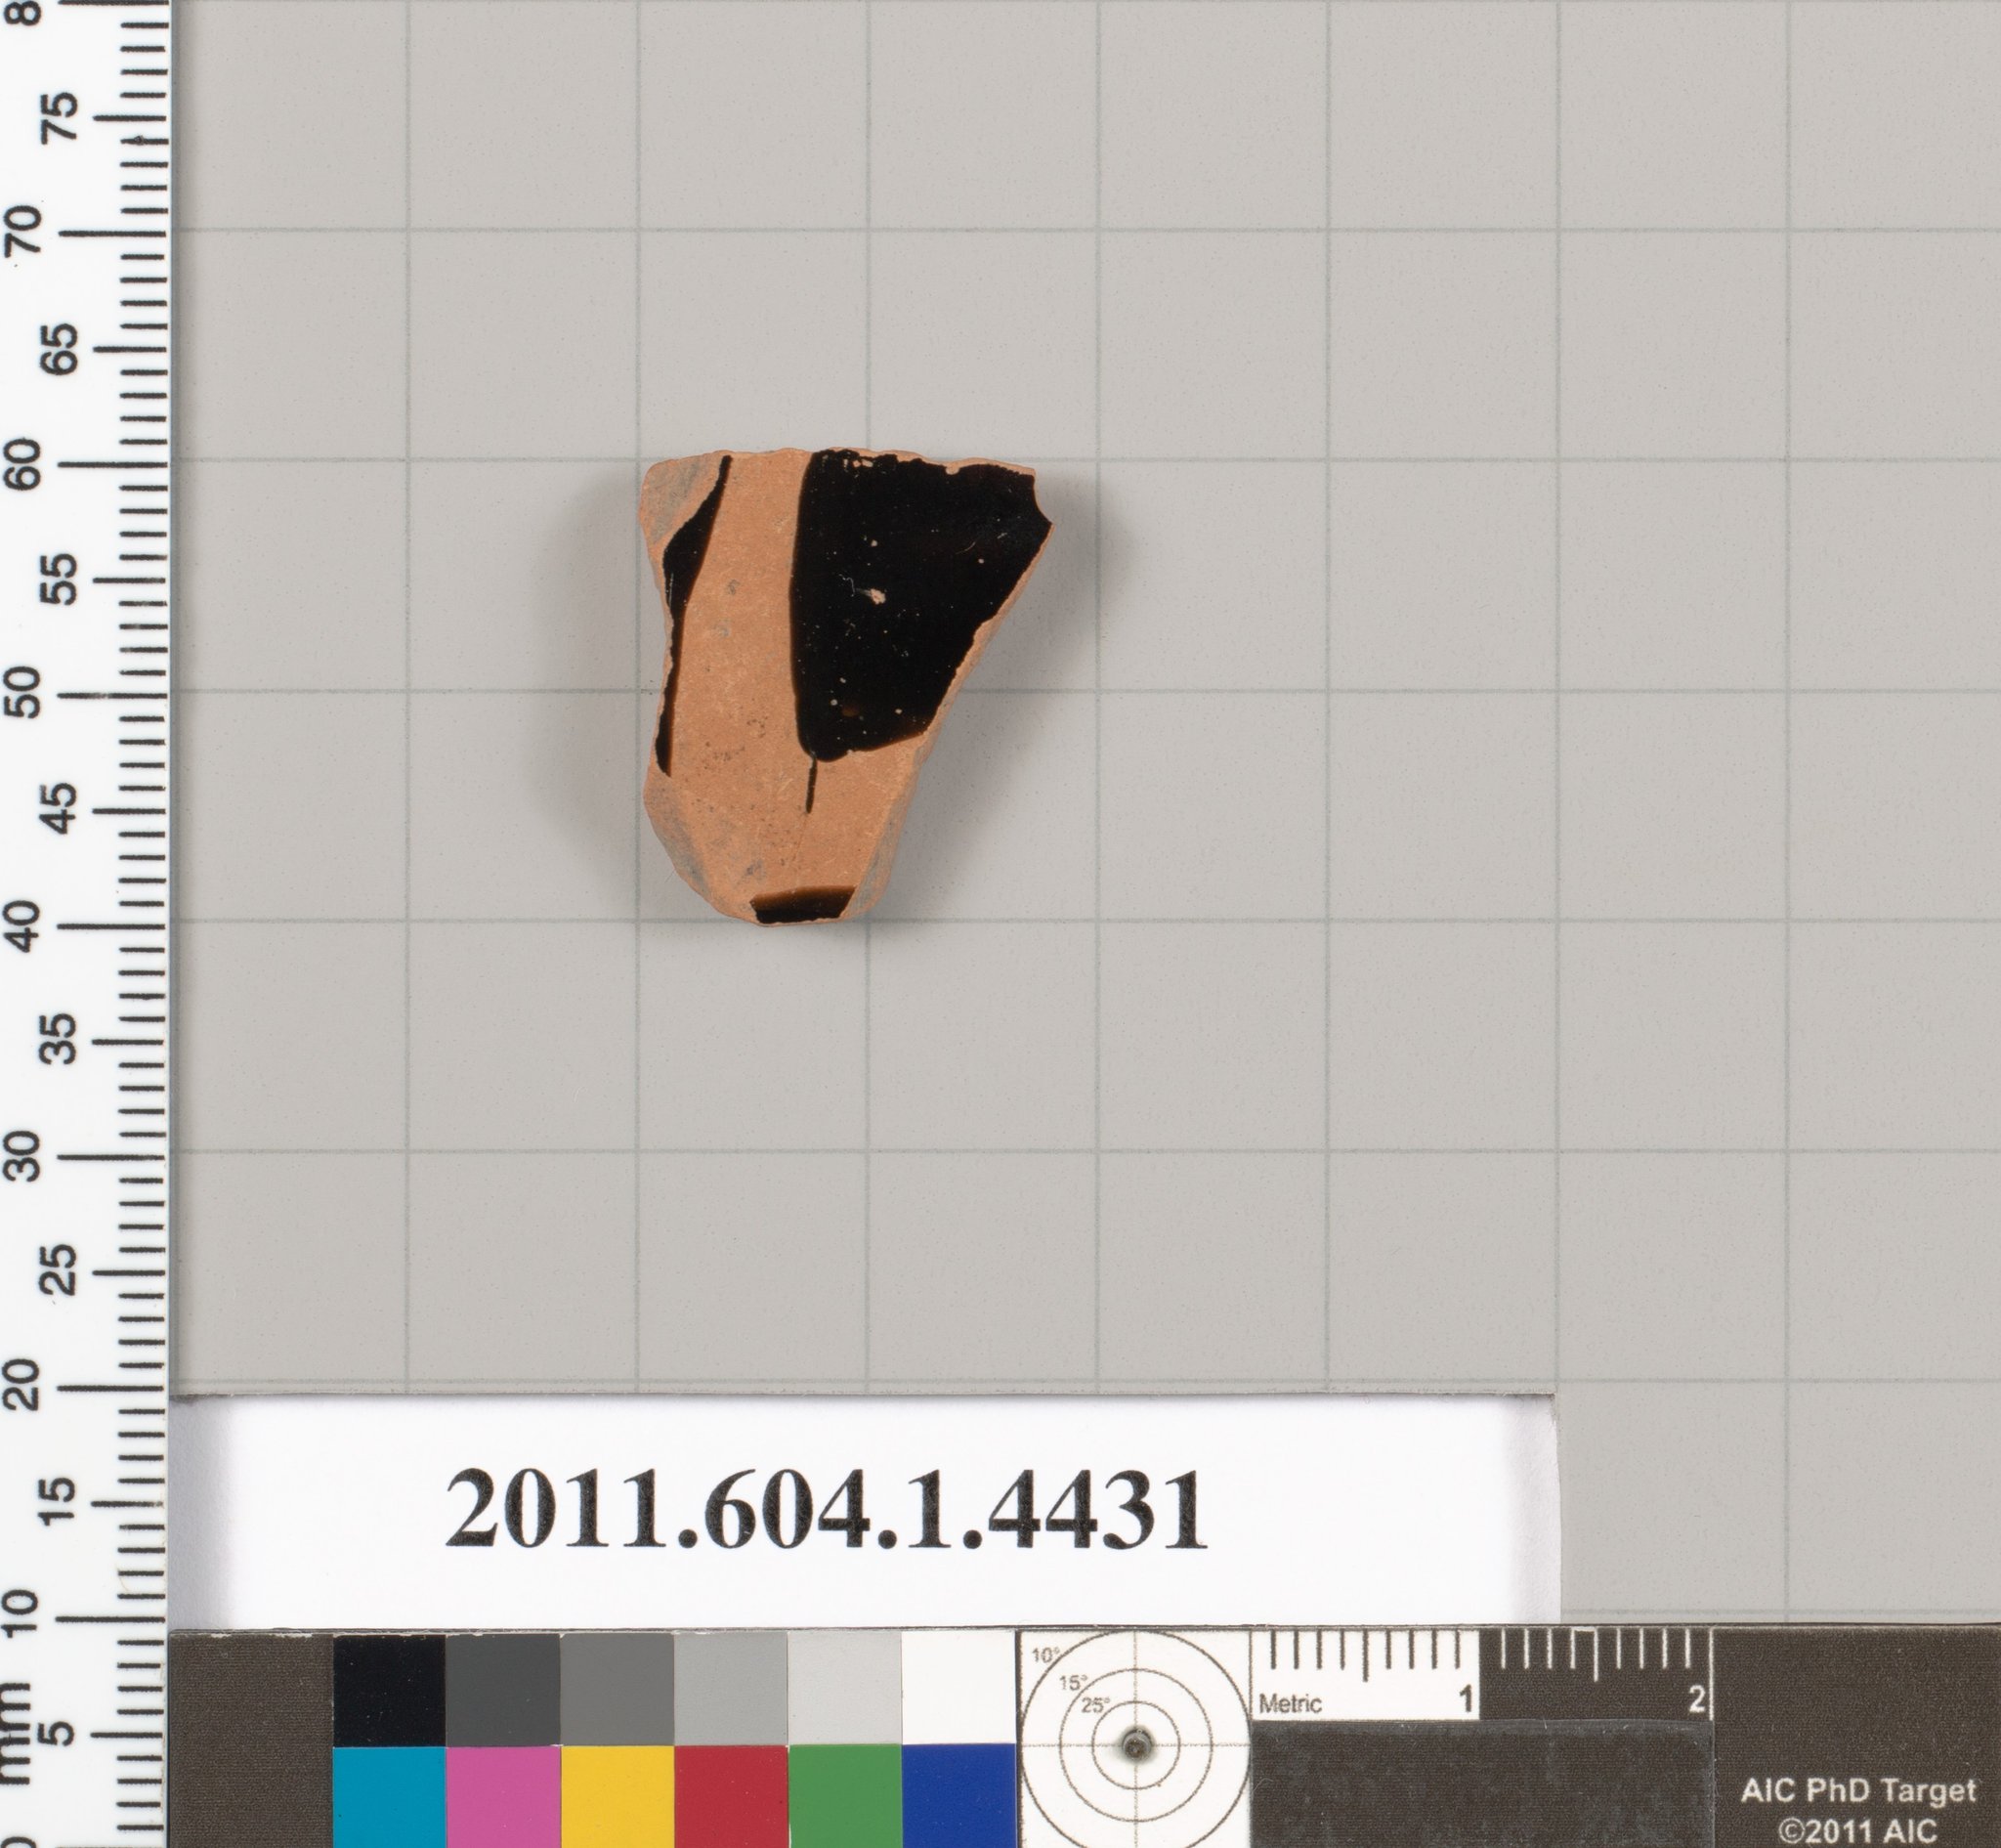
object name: kylix fragment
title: Terracotta fragment of a kylix (drinking cup)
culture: greek, attic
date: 475-451 BCE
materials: terracotta